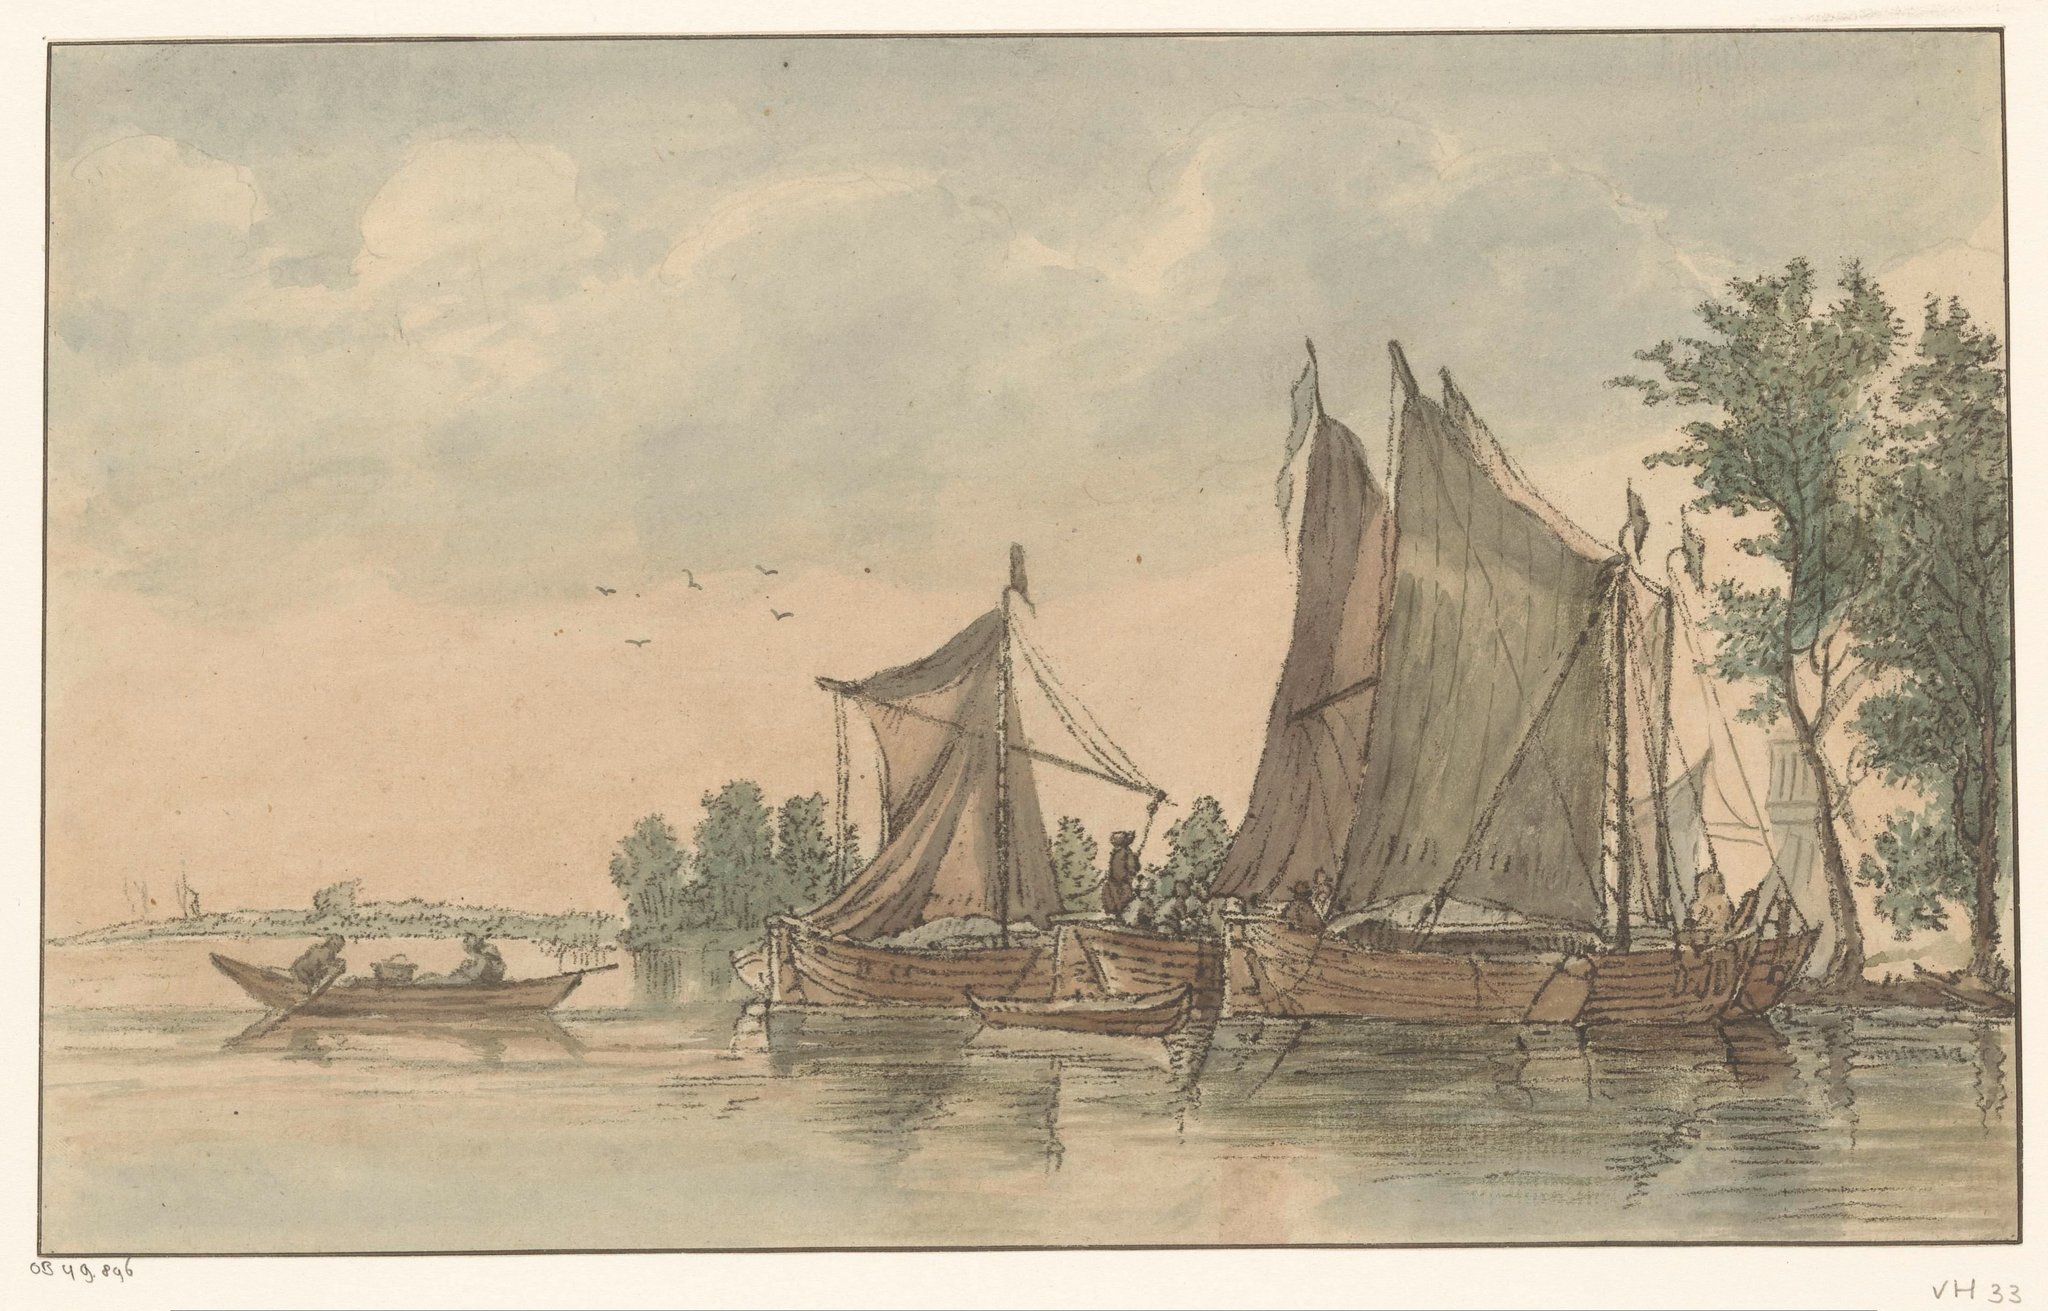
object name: print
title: Riviergezicht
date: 1795-1821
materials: paper, watercolor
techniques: etching, hand coloring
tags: sailing-ship, sailing-boat, river, traffic on the water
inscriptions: collector's mark: Lugt 12, collector's mark: Lugt 2725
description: Prent uit: Collection d'imitations de dessins d'après les principaux maîtres hollandais et flamands. Londen: C. Josi, 1821. De proefdruk van deze prent is tevens in bezit van het RMA.